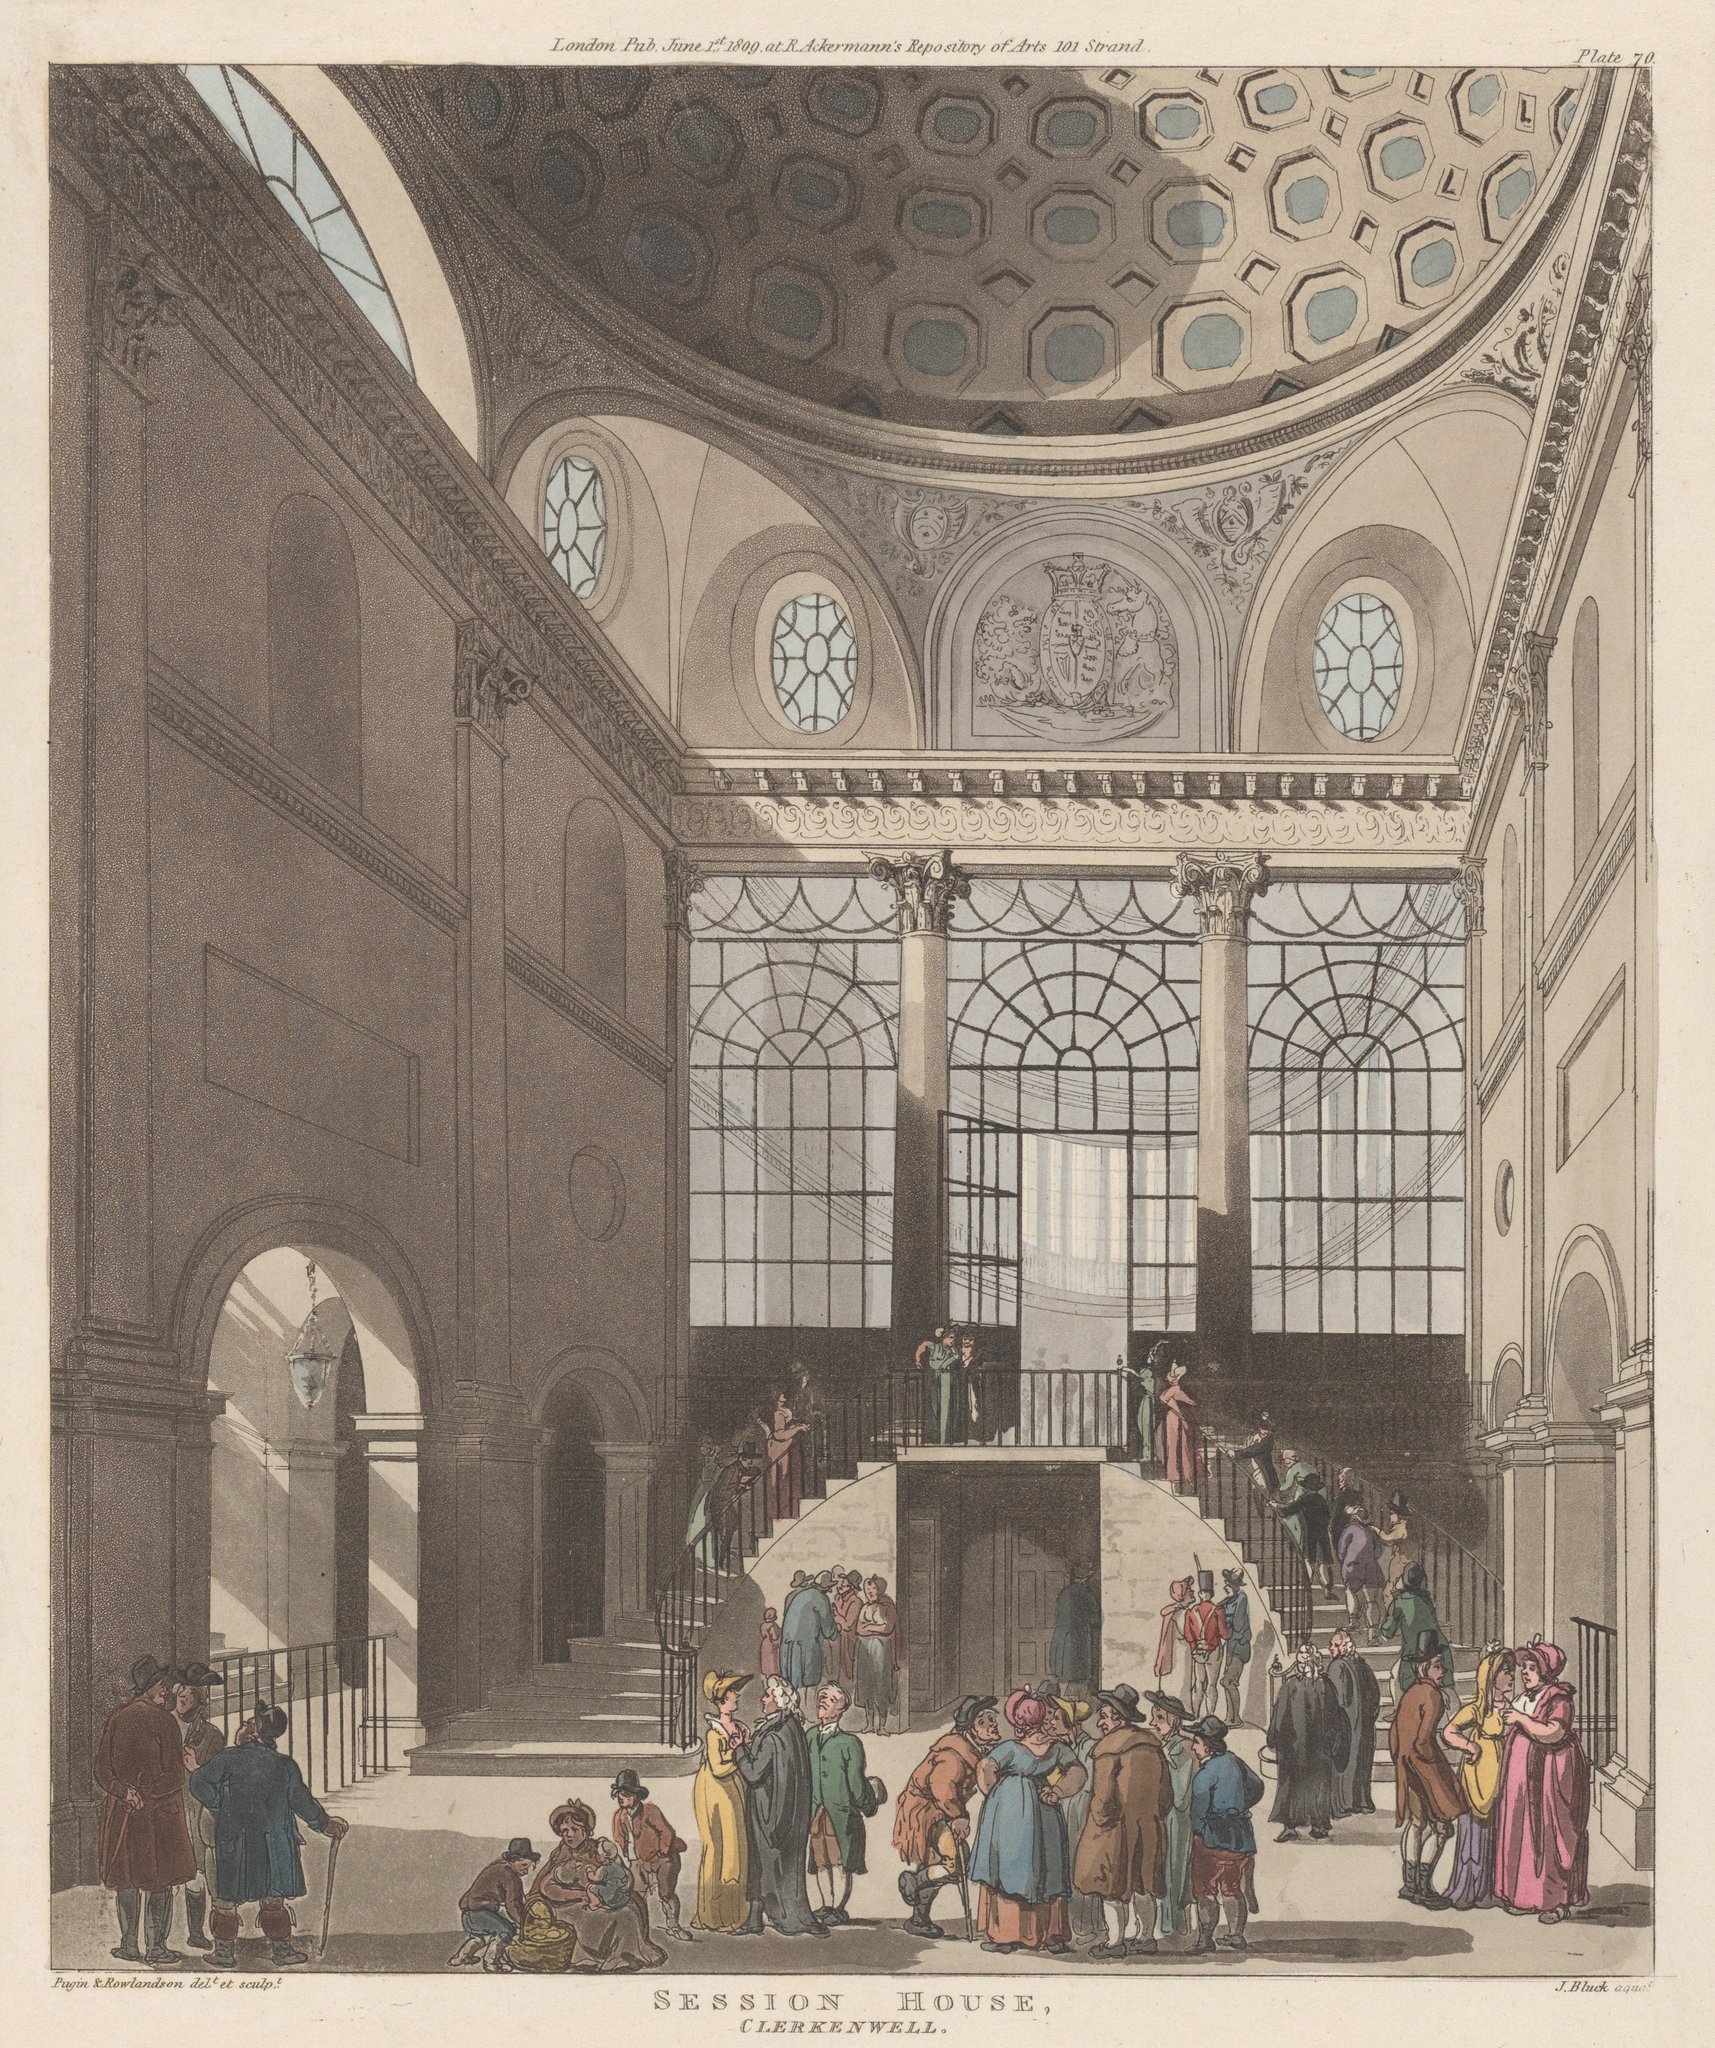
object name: print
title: Session House, Clerkenwell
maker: thomas rowlandson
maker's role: artist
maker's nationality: british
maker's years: 1757-1827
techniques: aquatint, etching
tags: architecture,interiors